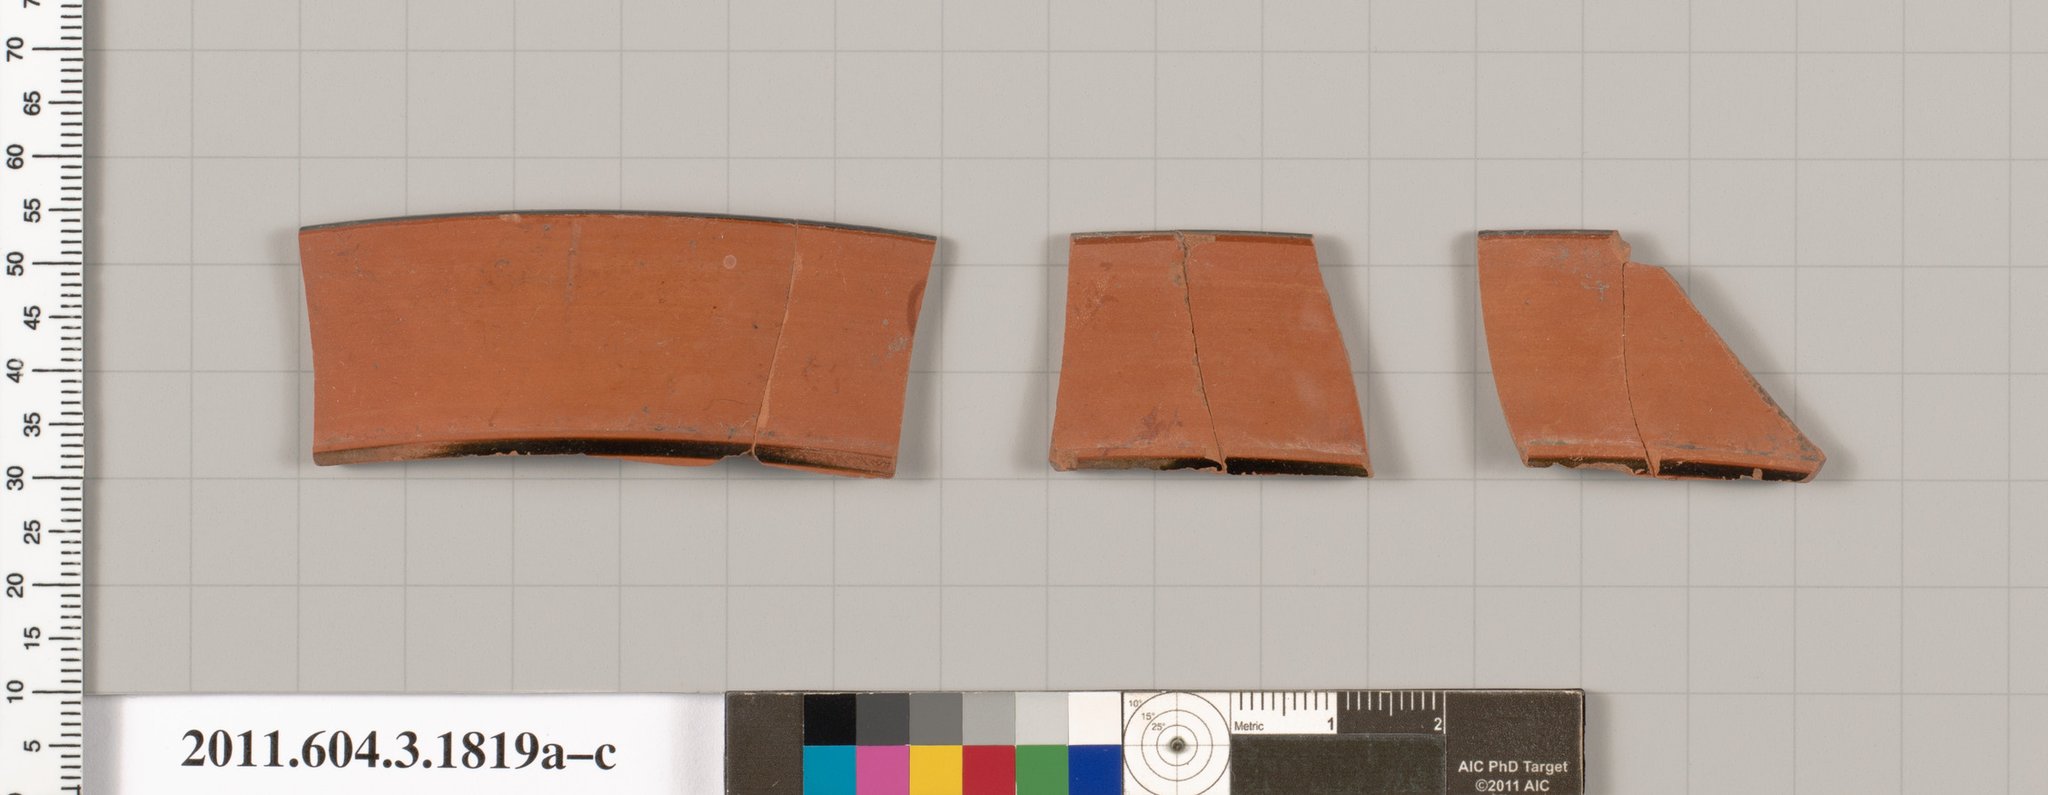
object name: kylix fragment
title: Terracotta rim fragments of kylikes: Lip cup (drinking cup)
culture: greek, attic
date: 560-525 BCE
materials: terracotta